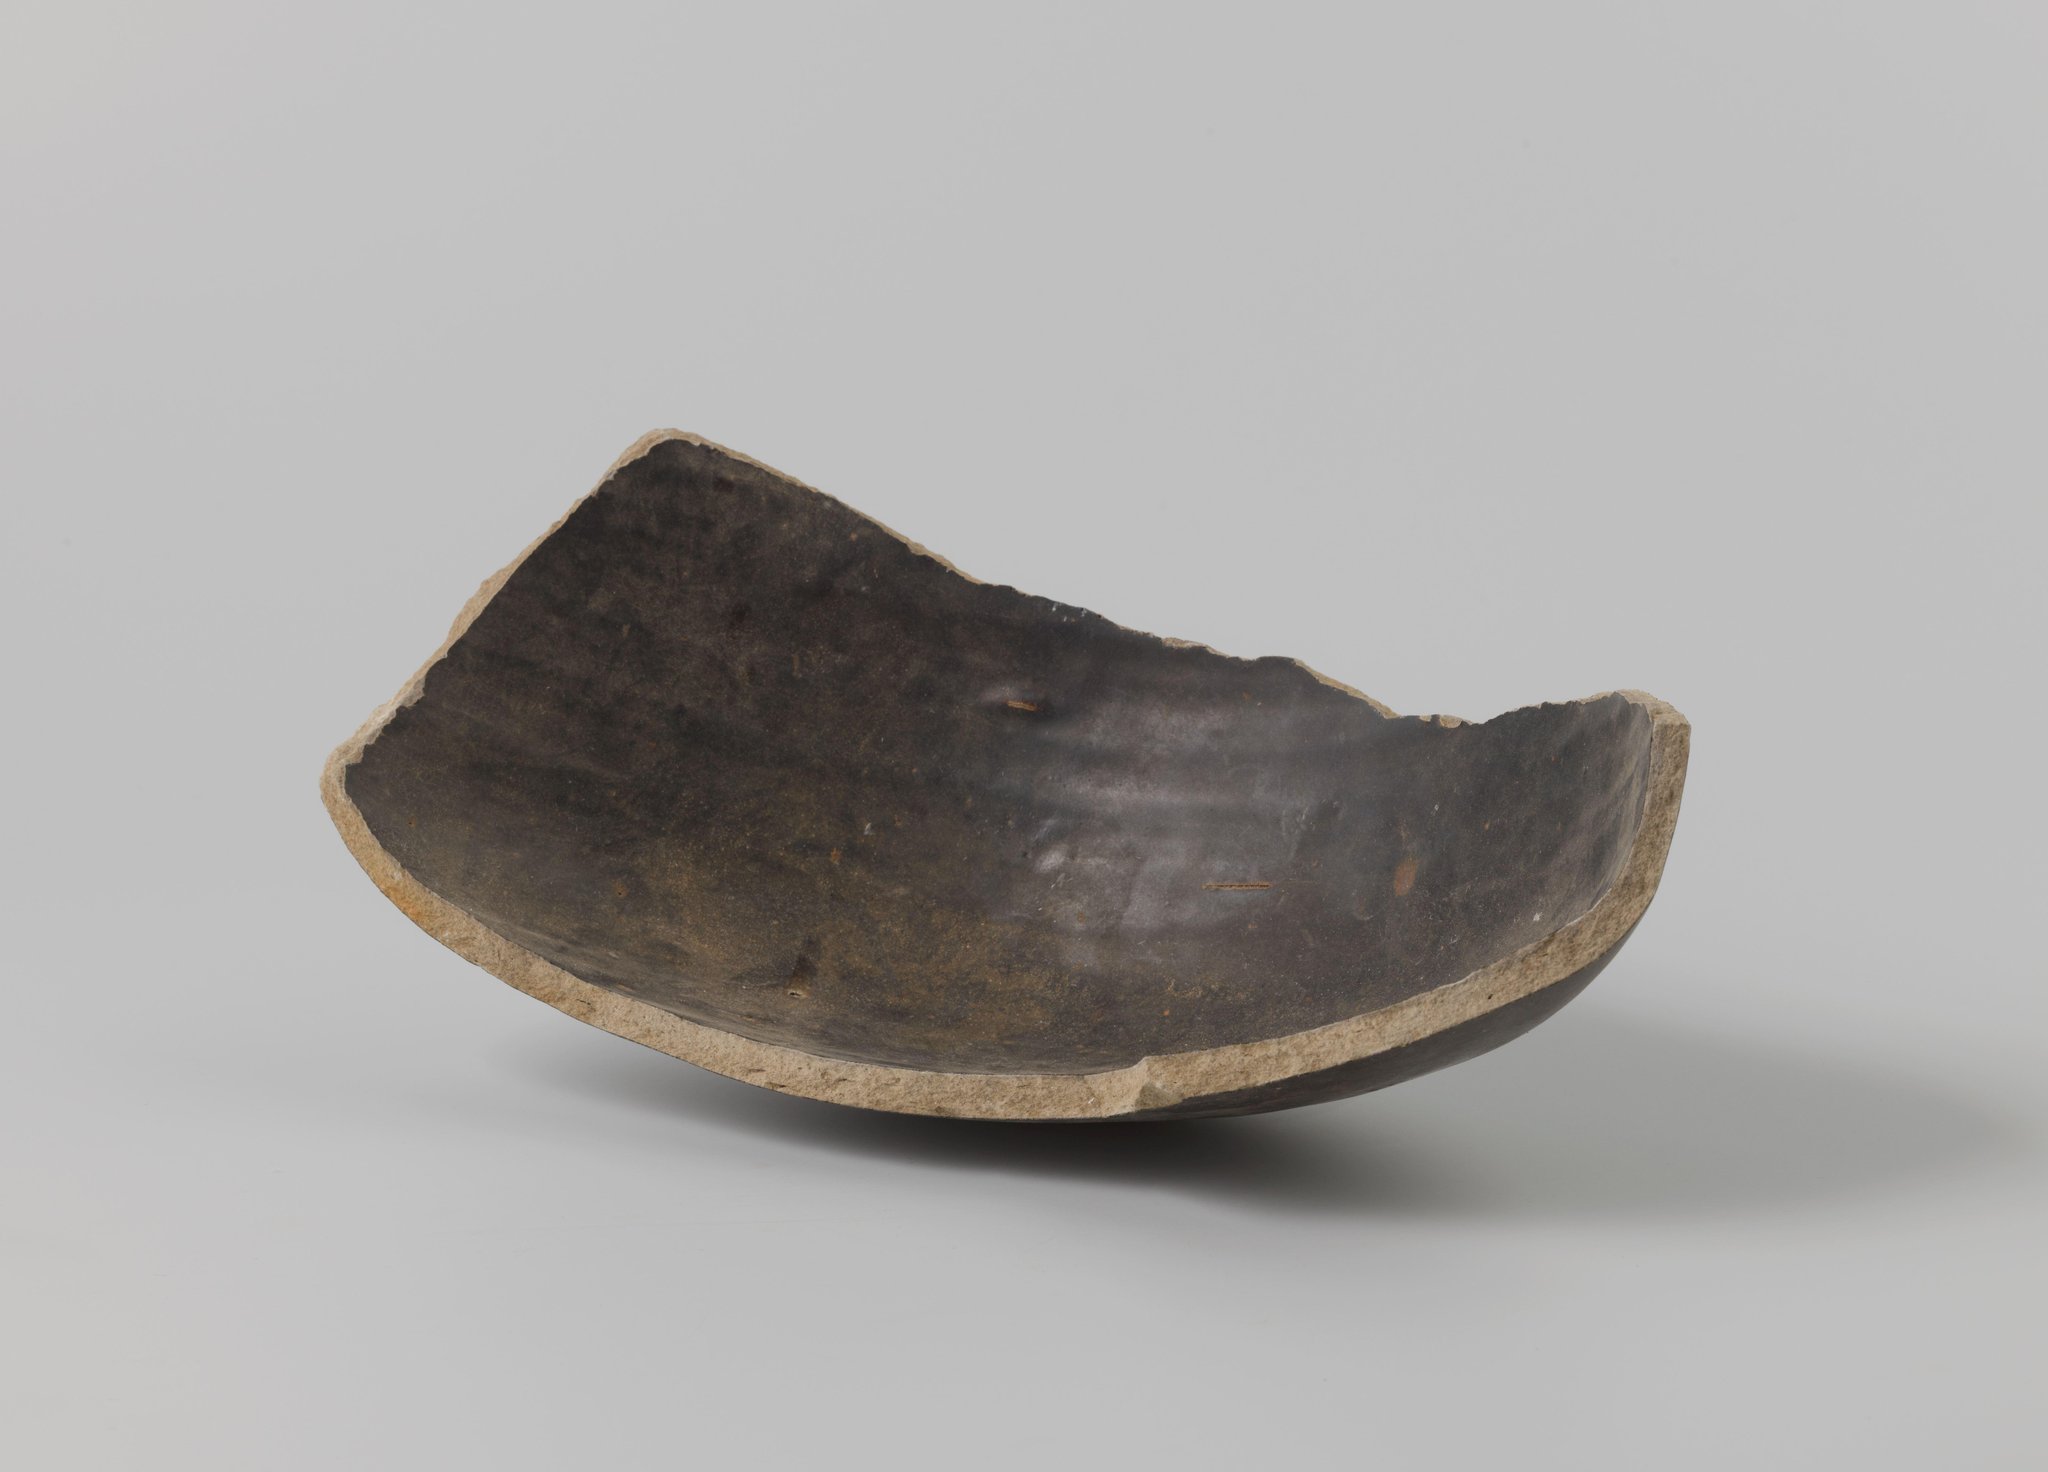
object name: sherd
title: Scherf van een martavaan uit V.O.C.-schip de 'Witte Leeuw'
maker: Anonymous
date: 1613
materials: porcelain, stoneware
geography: southeast asia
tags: verenigde oostindische compagnie, sint-helena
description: A jar. This exceptional jar has a wide waist and narrows towards the neck which ends in a narrow flaring mouth. The thin, double walled base has bursted open. The grey coloured clay contains few impurities. There are no traces of glaze on the outside or inside. It ha possibly been covered with a glaze or a slip. The upper half of the exterior has concentric grooves neatly incised from the neck to the waist.